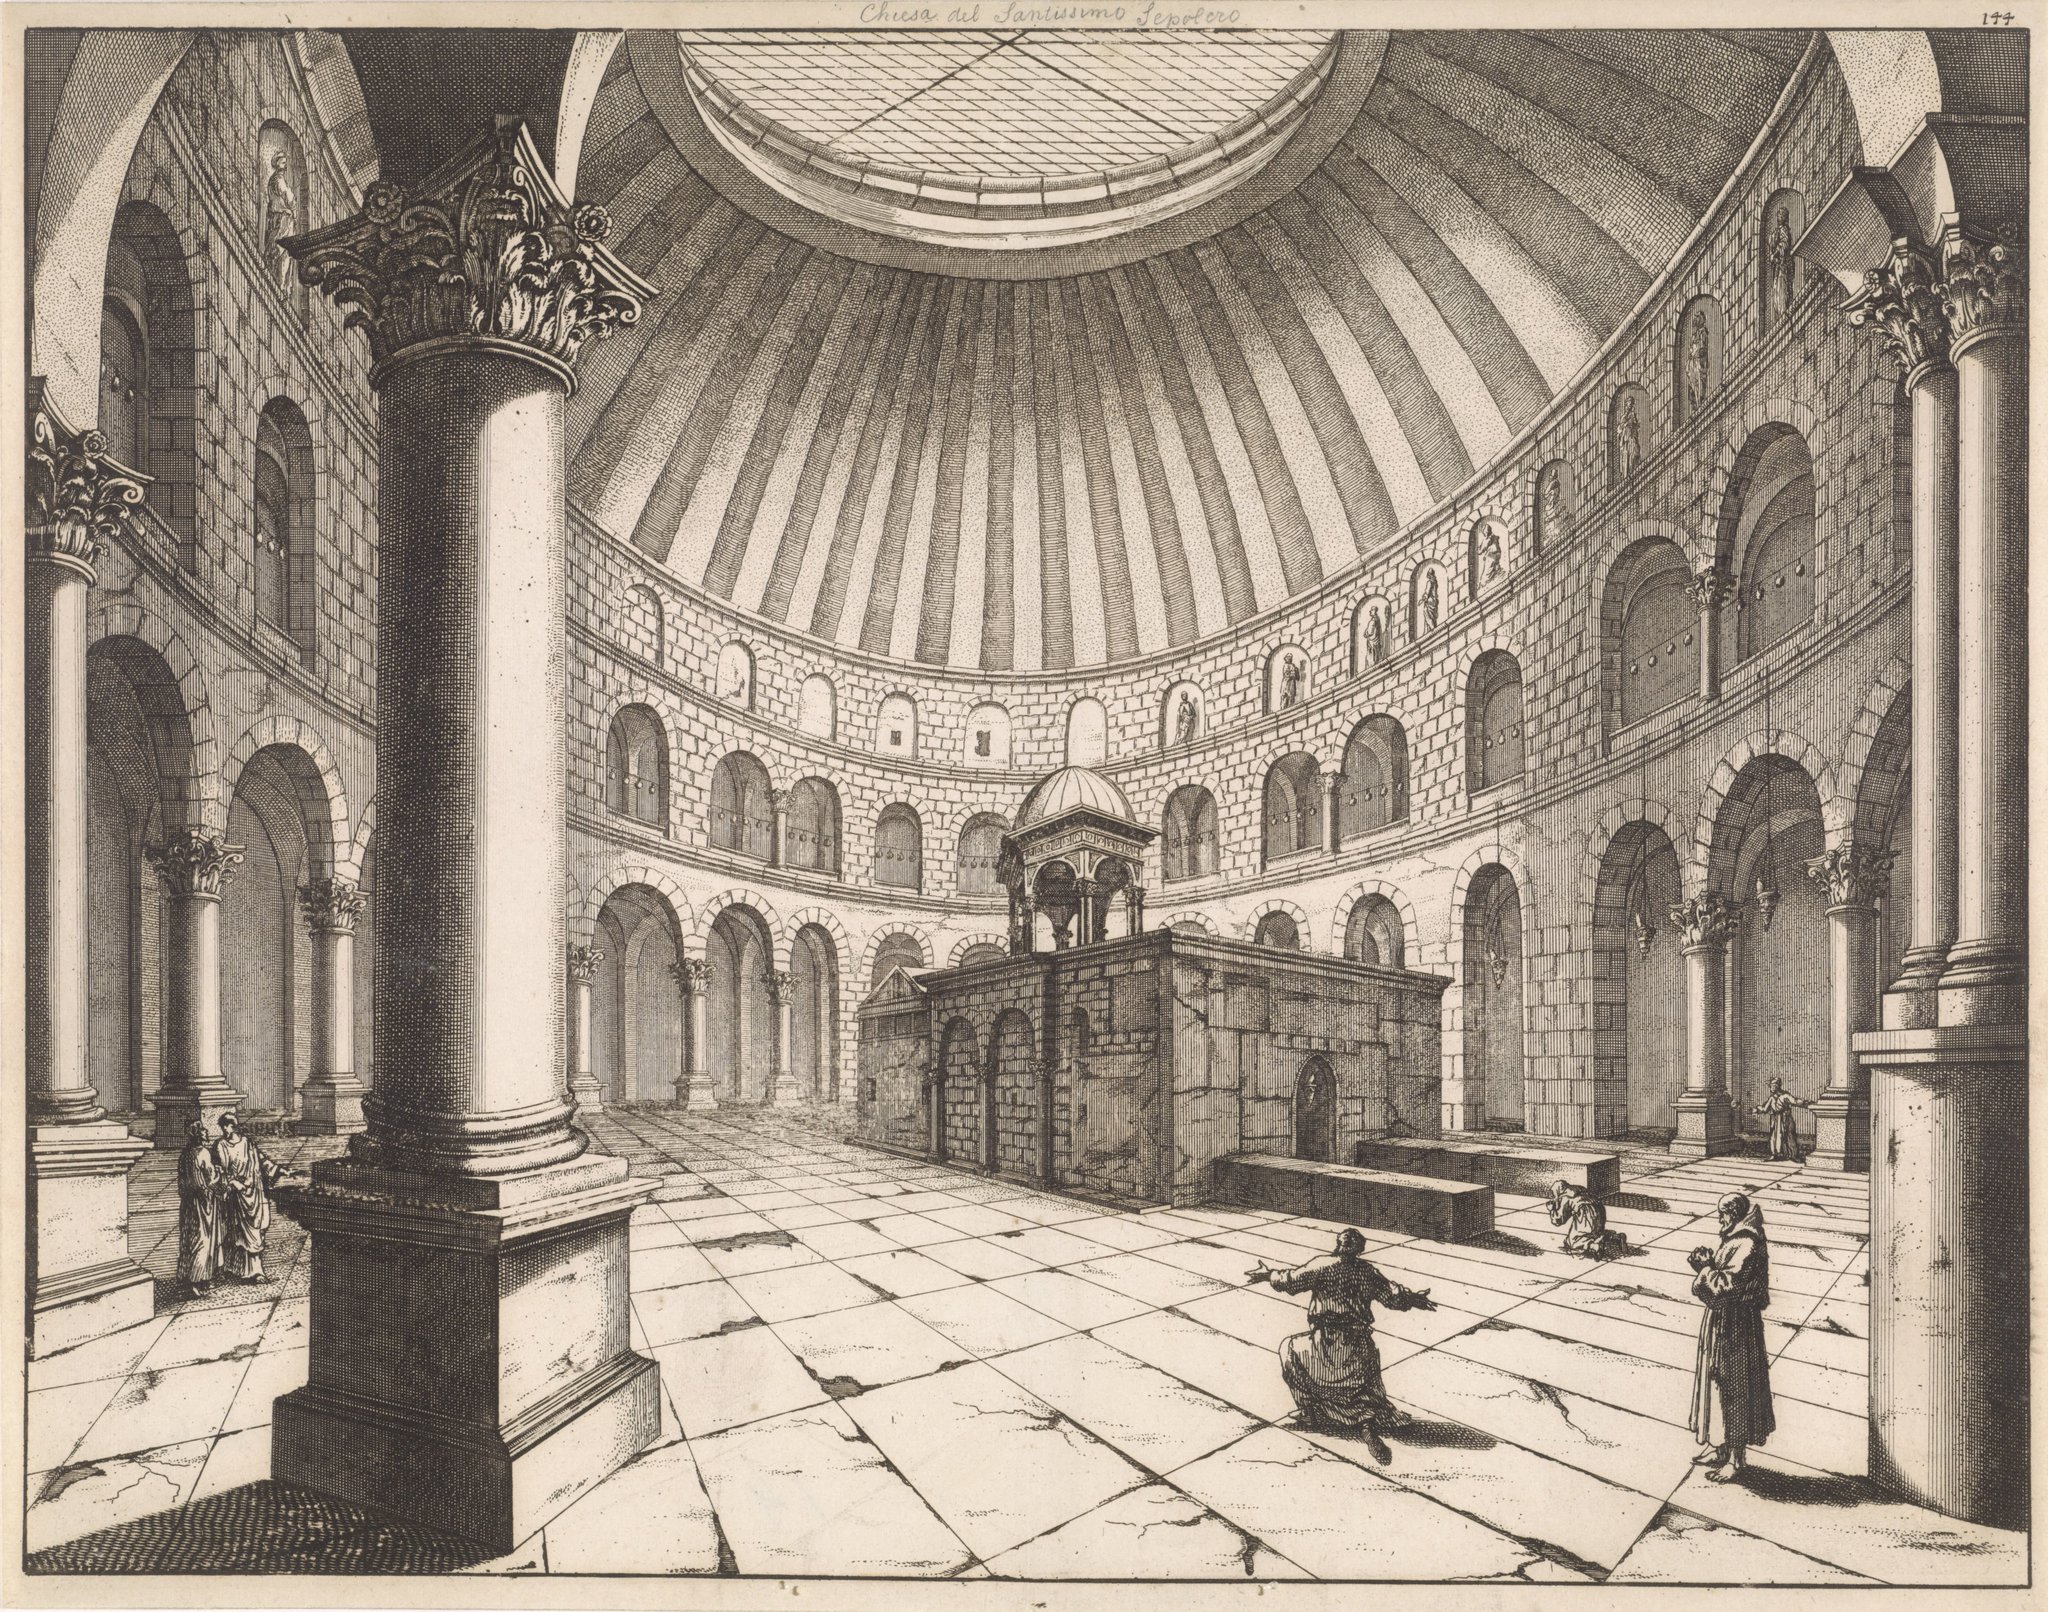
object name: print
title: Interieur van de Heilig-Grafkerk te Jeruzalem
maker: jan luyken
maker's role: draughtsman, print maker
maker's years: 1649-1712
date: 1698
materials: paper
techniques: engraving, etching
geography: amsterdam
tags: (architectonic) structure representing or symbolizing the holy sepulchre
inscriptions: inscription: ‘Chiesa del santissimo Sepolero’, collector's mark: Lugt 2228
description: Gebruikt als illustratie in: Bruyn, Cornelis. Reizen van Cornelis de Bruyn, door de vermaardste deelen van Klein Asia. Delft: Hendrik van Kroonevelt, 1698, p. 282.